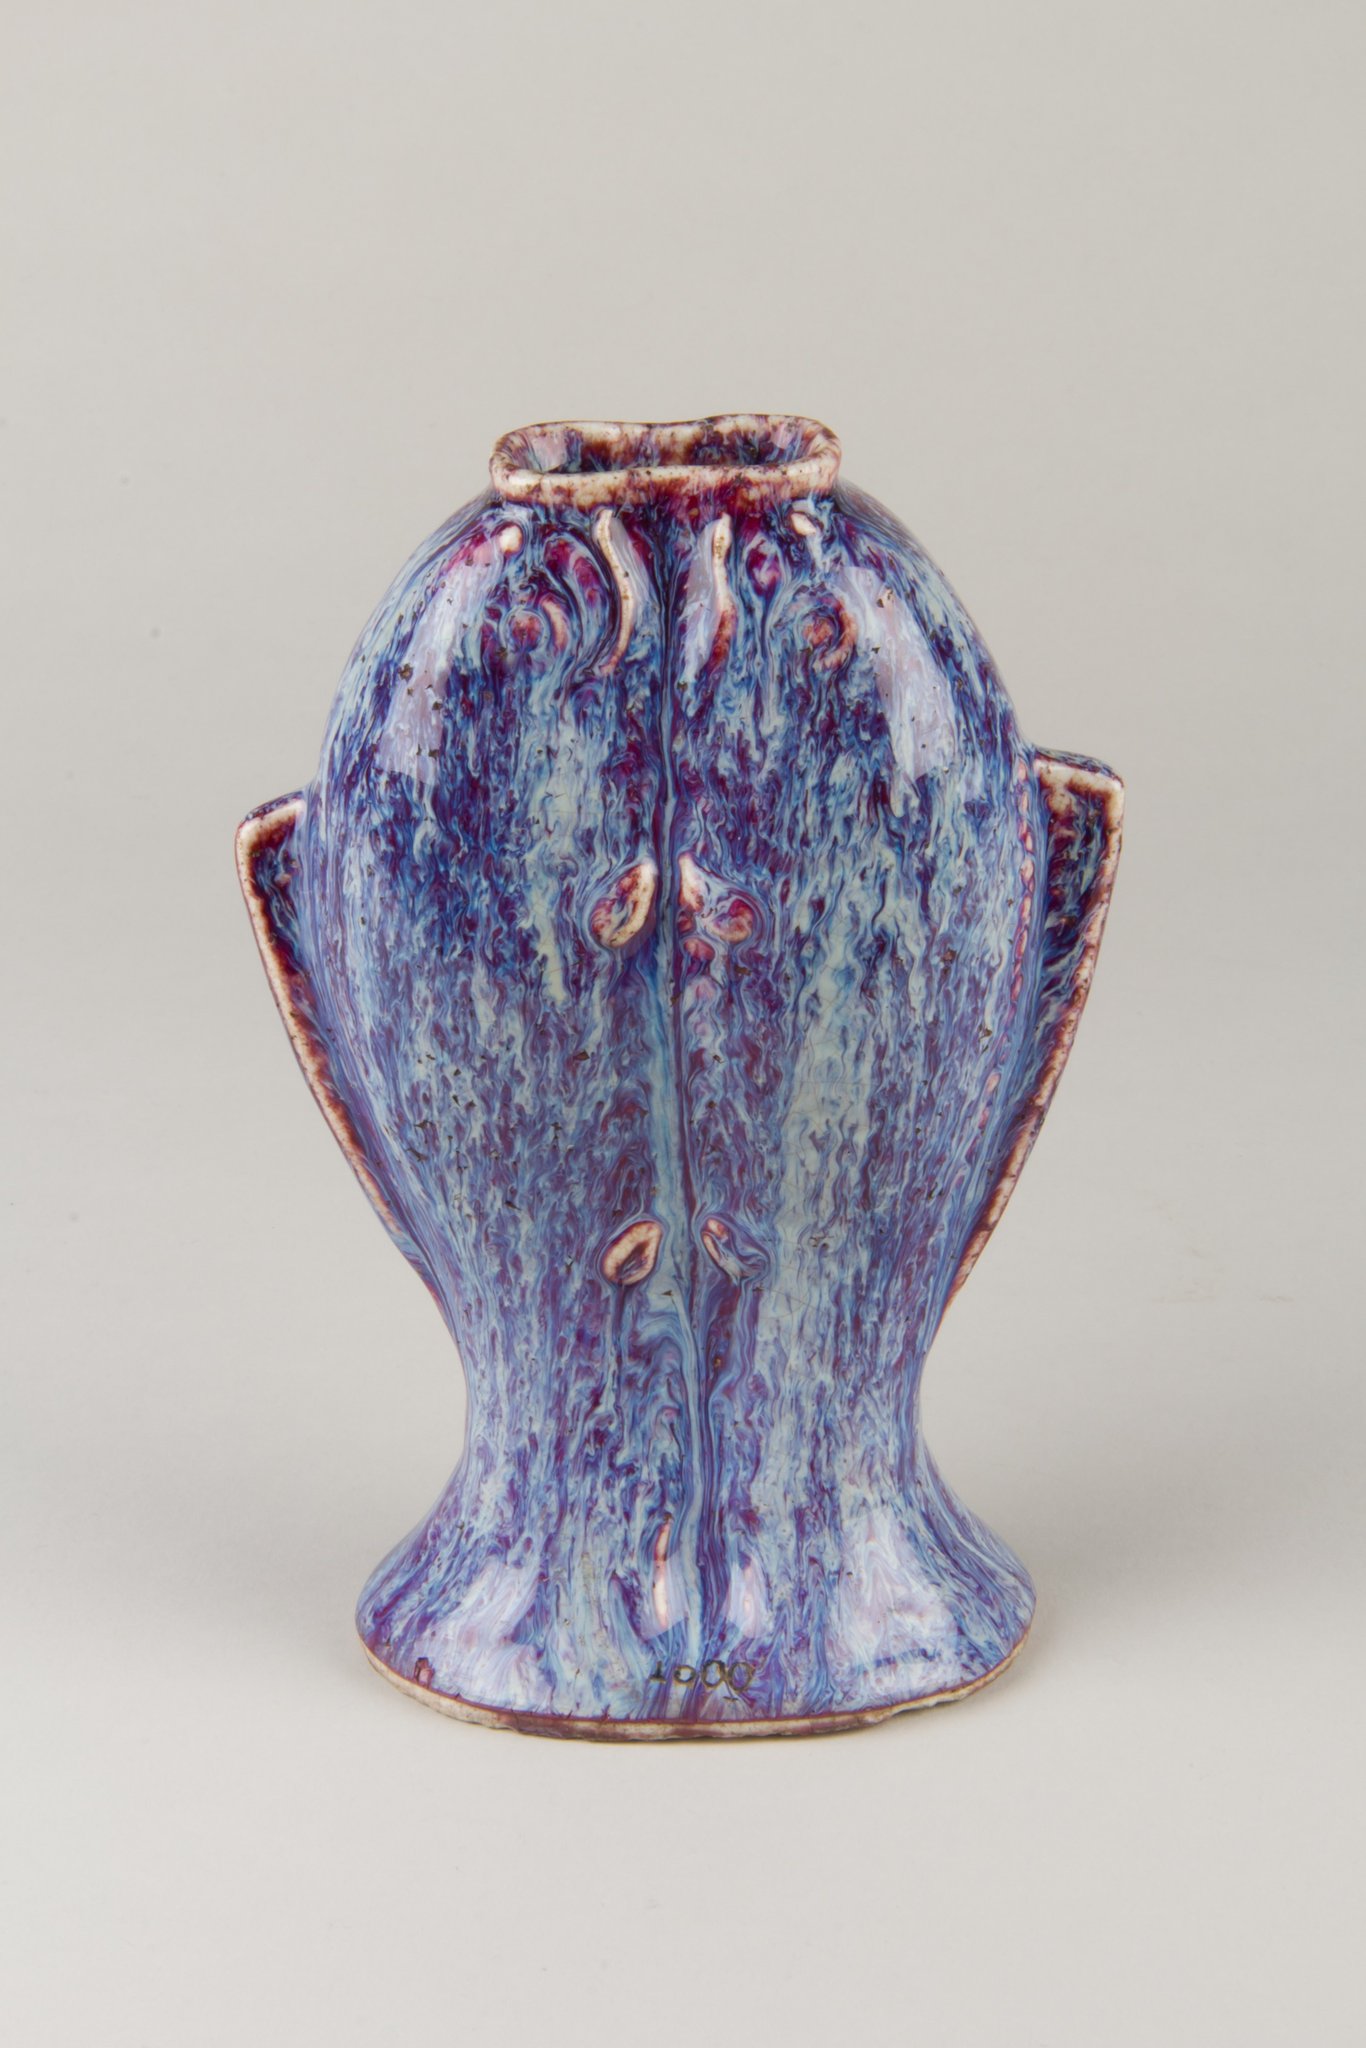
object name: vase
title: Vase in the form of twin fish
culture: chinese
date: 1767-1800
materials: glaze, porcelain